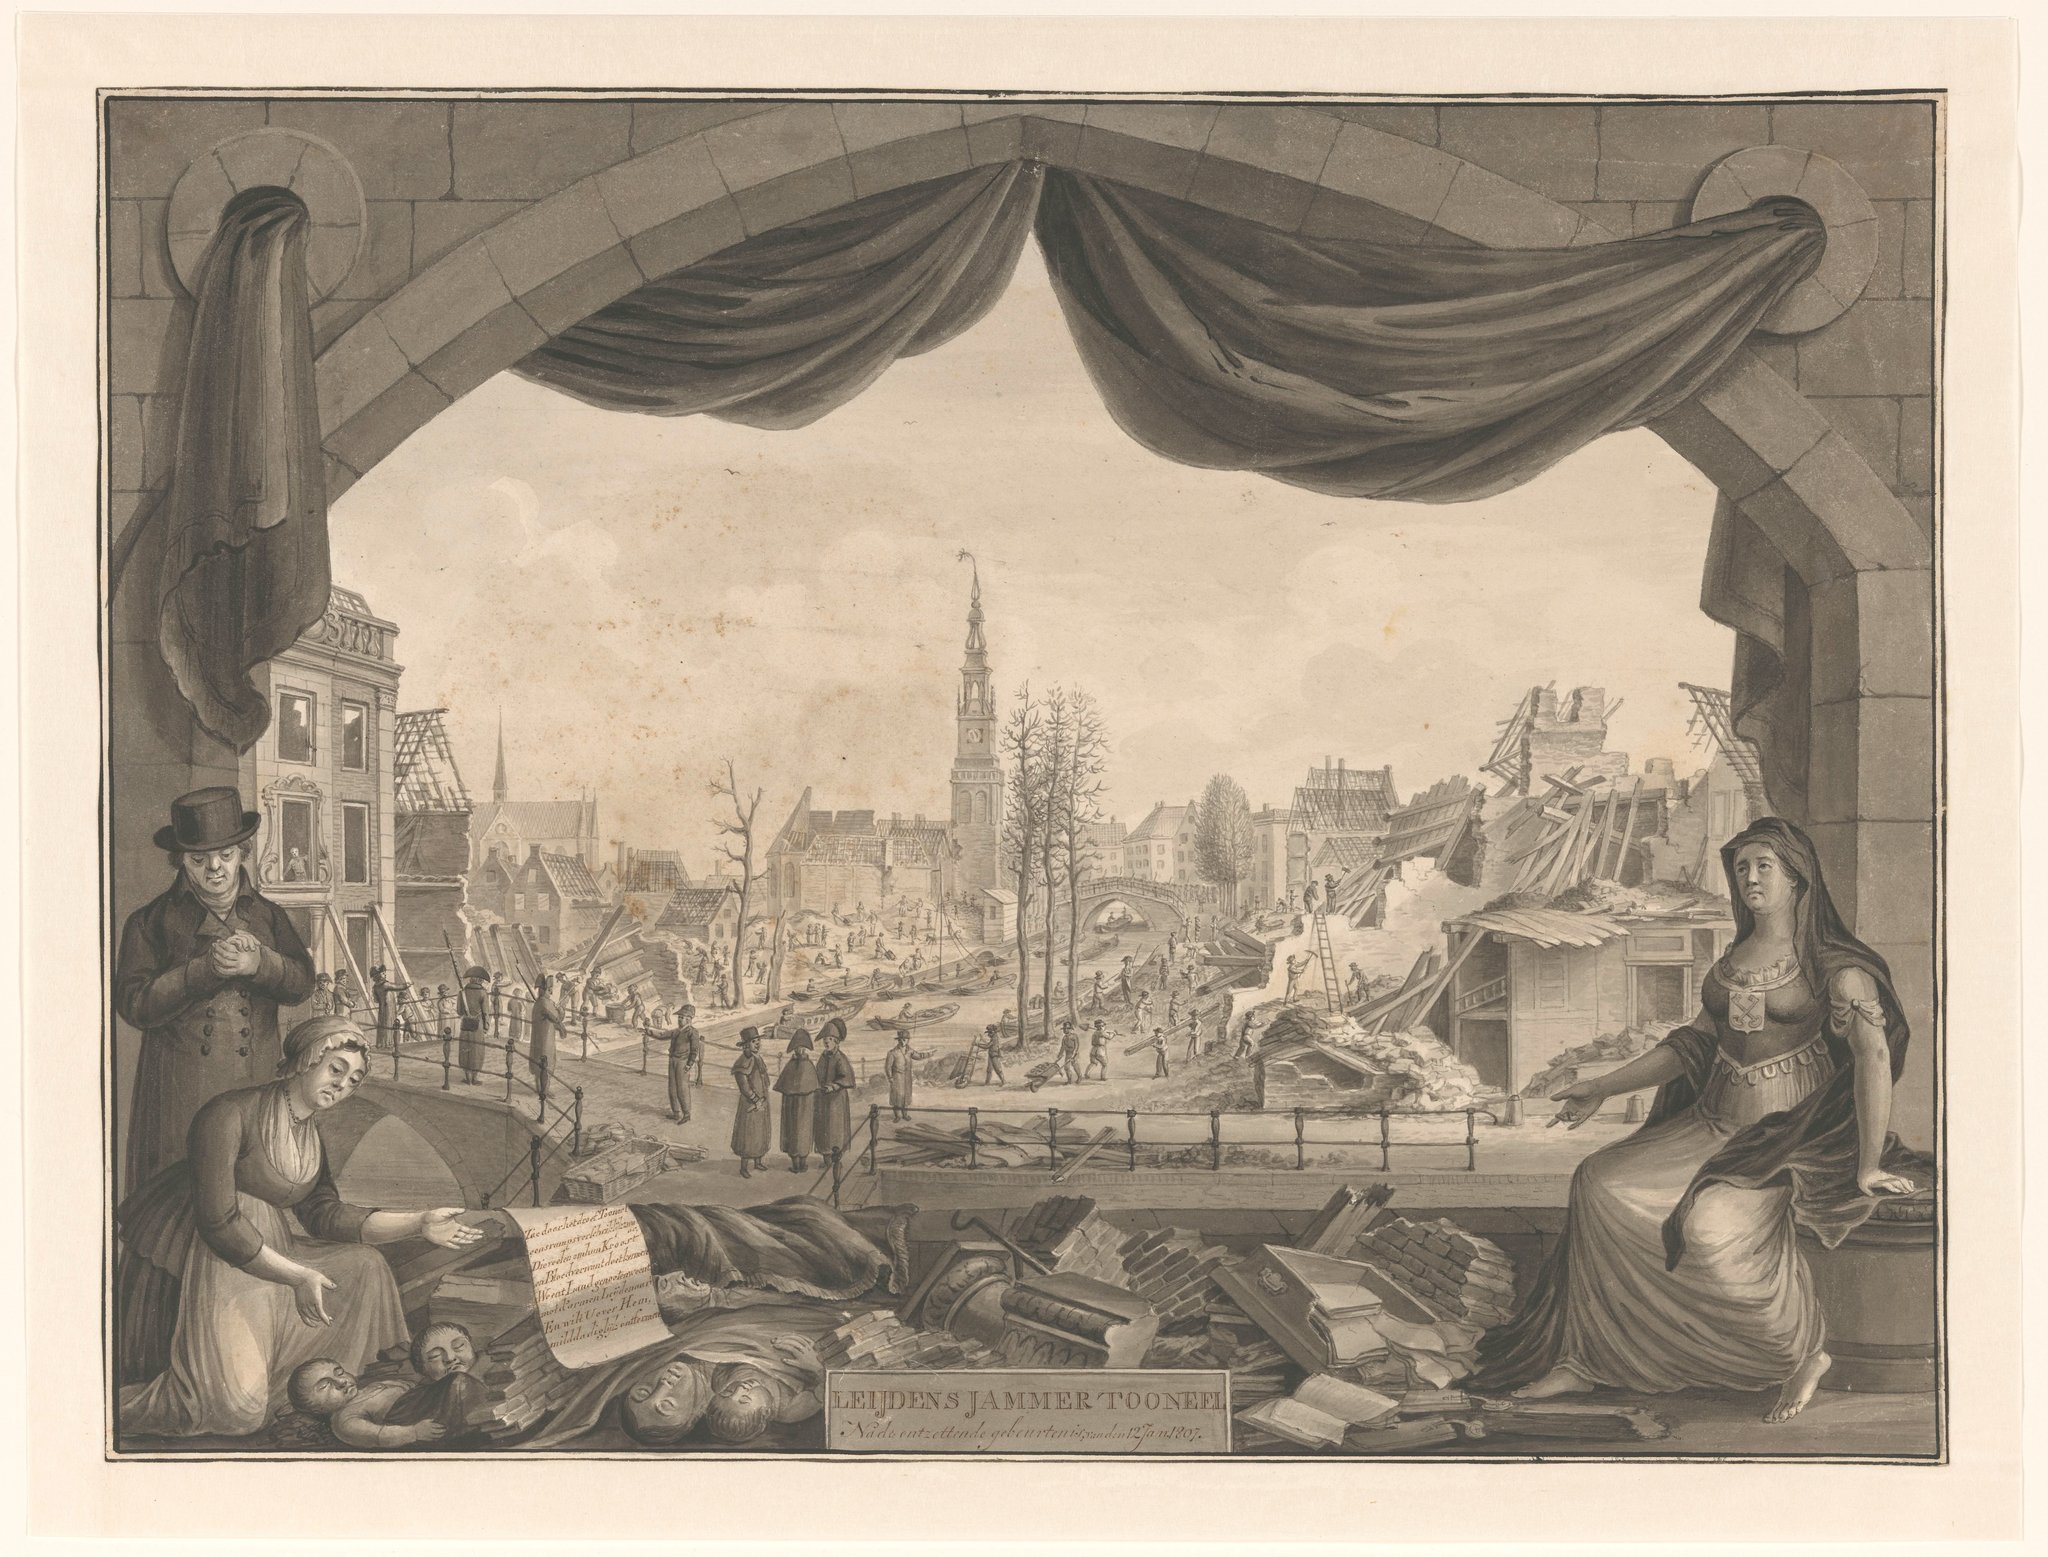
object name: drawing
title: Leidens Jammer Toneel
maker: christiaan van waardt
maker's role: painter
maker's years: 1761-1820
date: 1807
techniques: brush, pen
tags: leiden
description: Gezicht op het Steenschuur, een gracht in het verlengde van het Rapenburg, Leiden, na de kruitramp van 12 januari 1807.